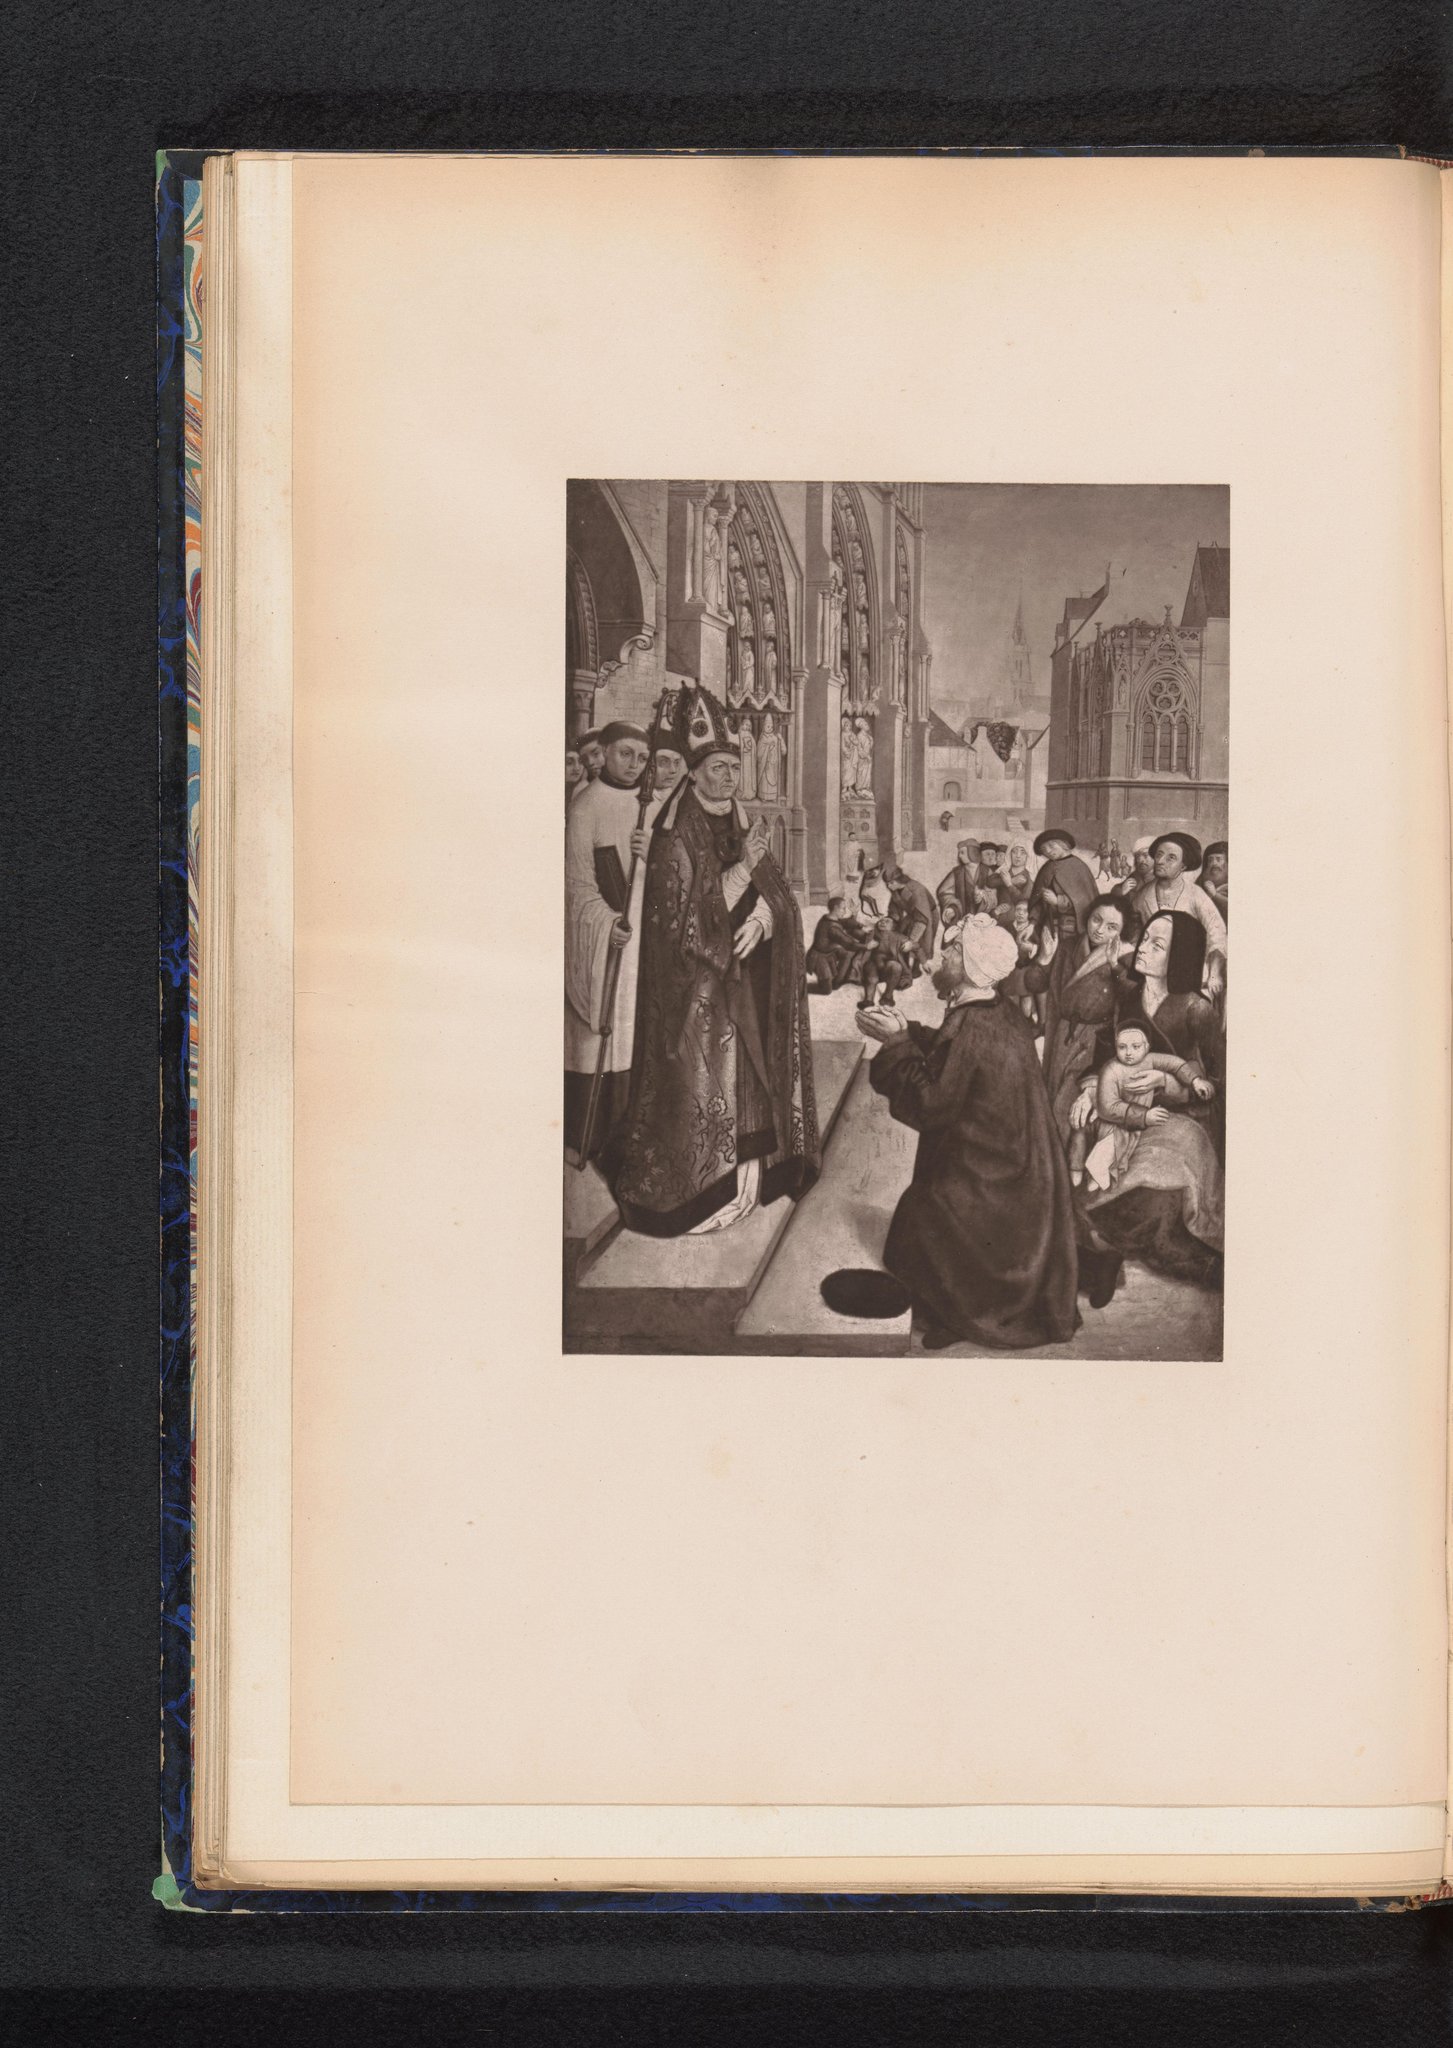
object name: reproduction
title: Reproductie van een schilderij van een zegenende bisschop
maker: Anonymous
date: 1878-1883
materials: paper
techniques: woodburytype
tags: theologian, blessing by the priest ~ holy mass